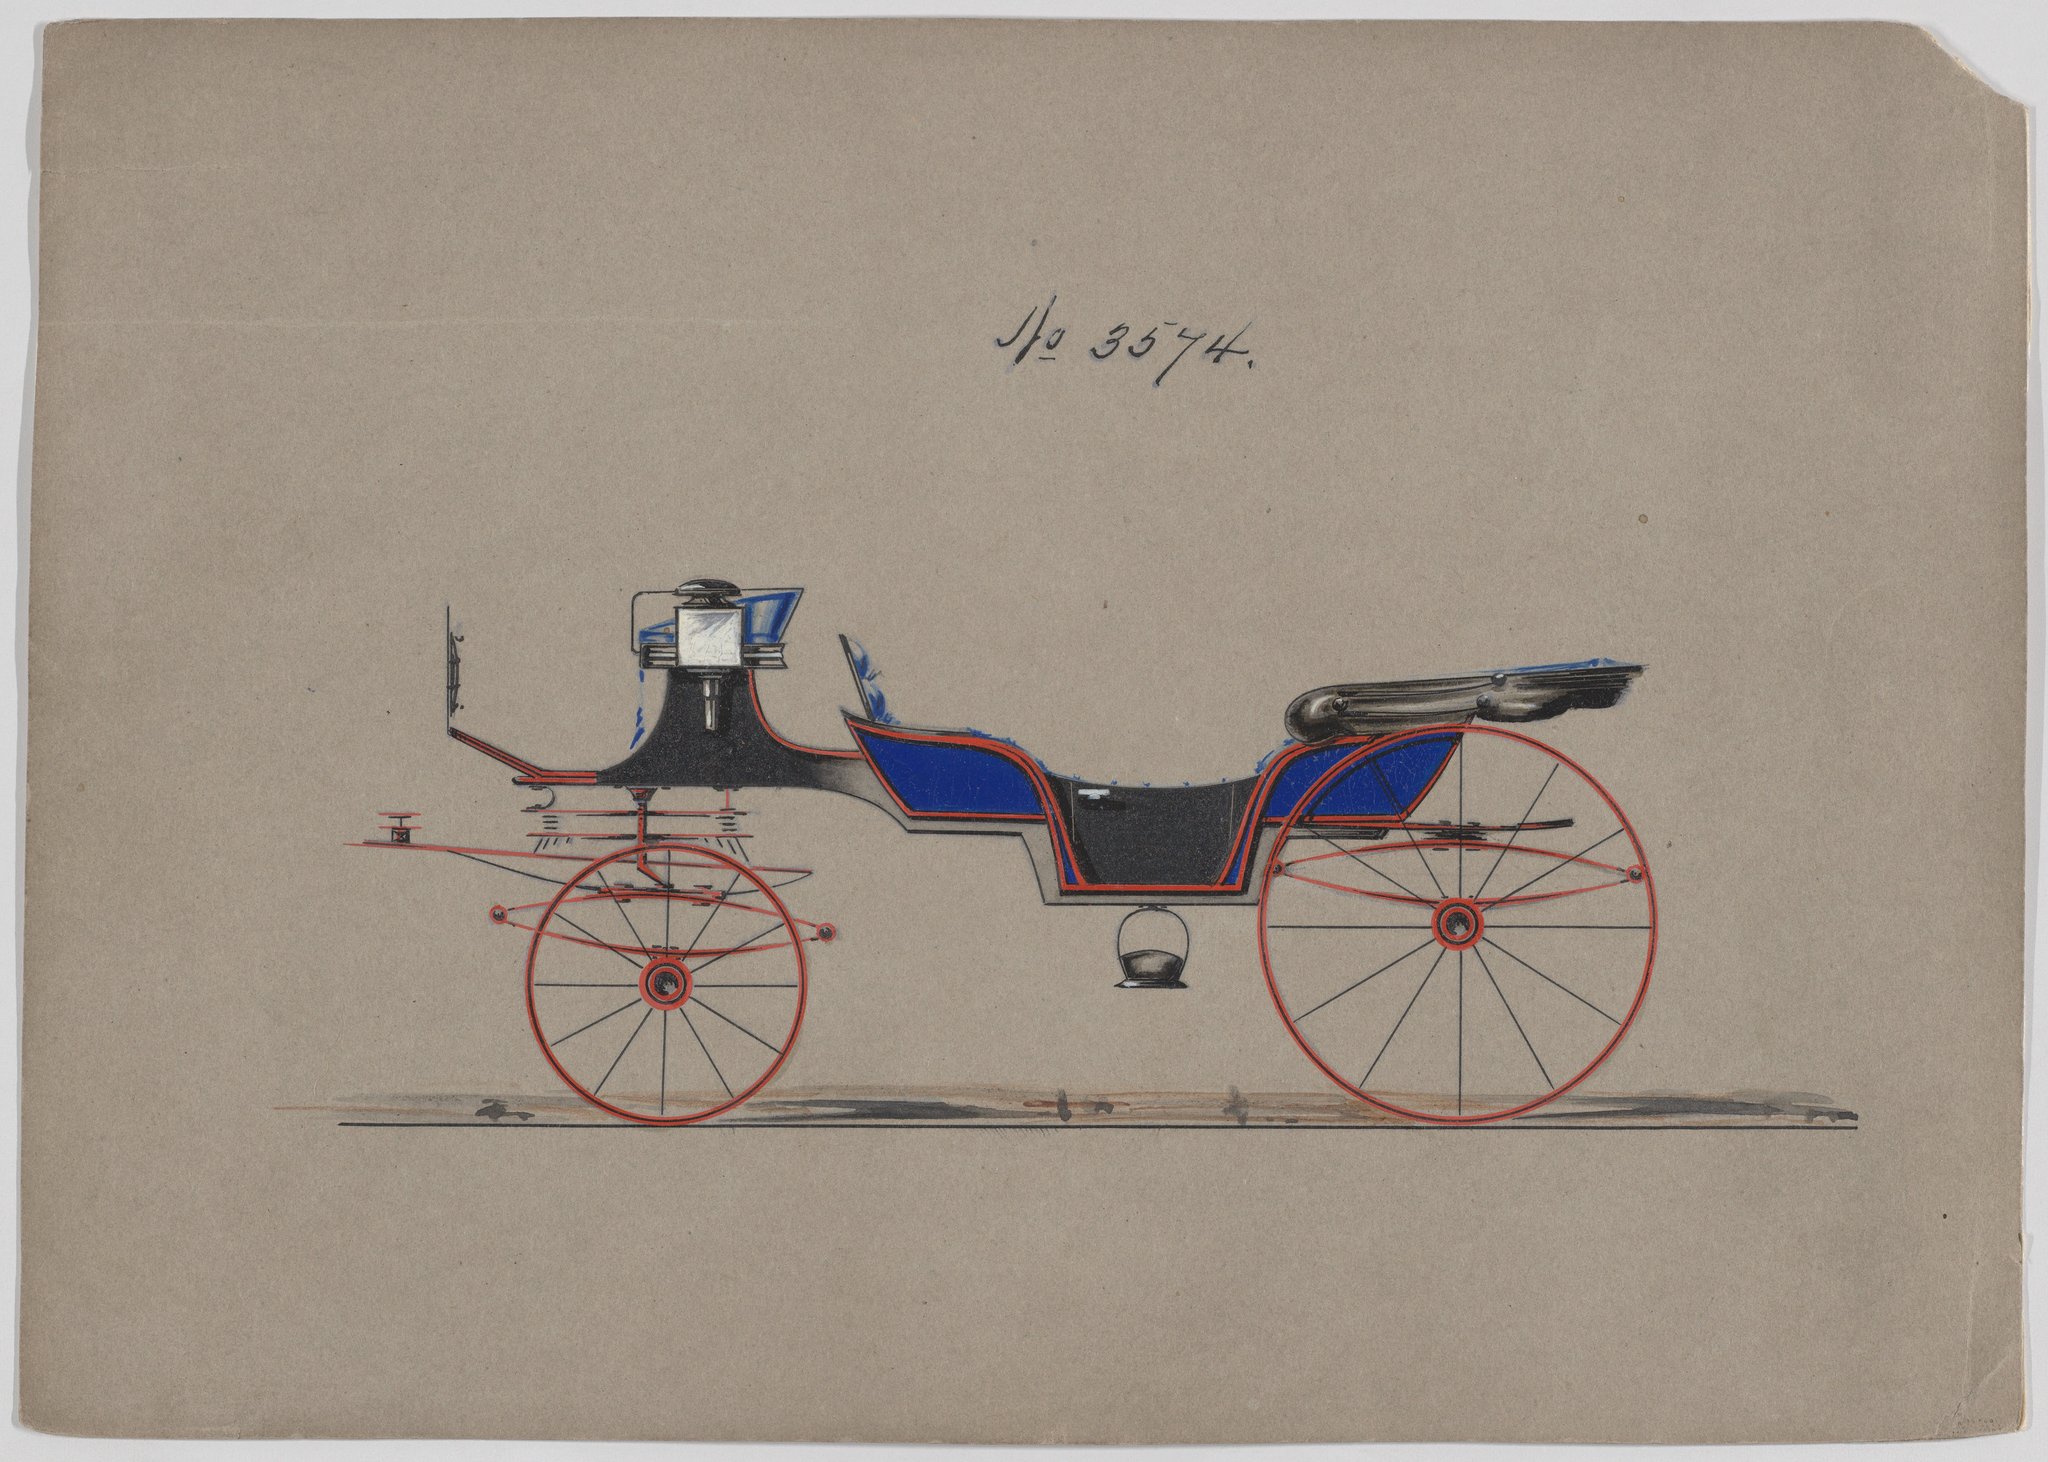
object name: drawing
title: Vis-à-vis #3574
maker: brewster & co.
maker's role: manufacturer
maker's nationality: american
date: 1880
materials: gouache, ink, watercolor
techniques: pen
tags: carriages